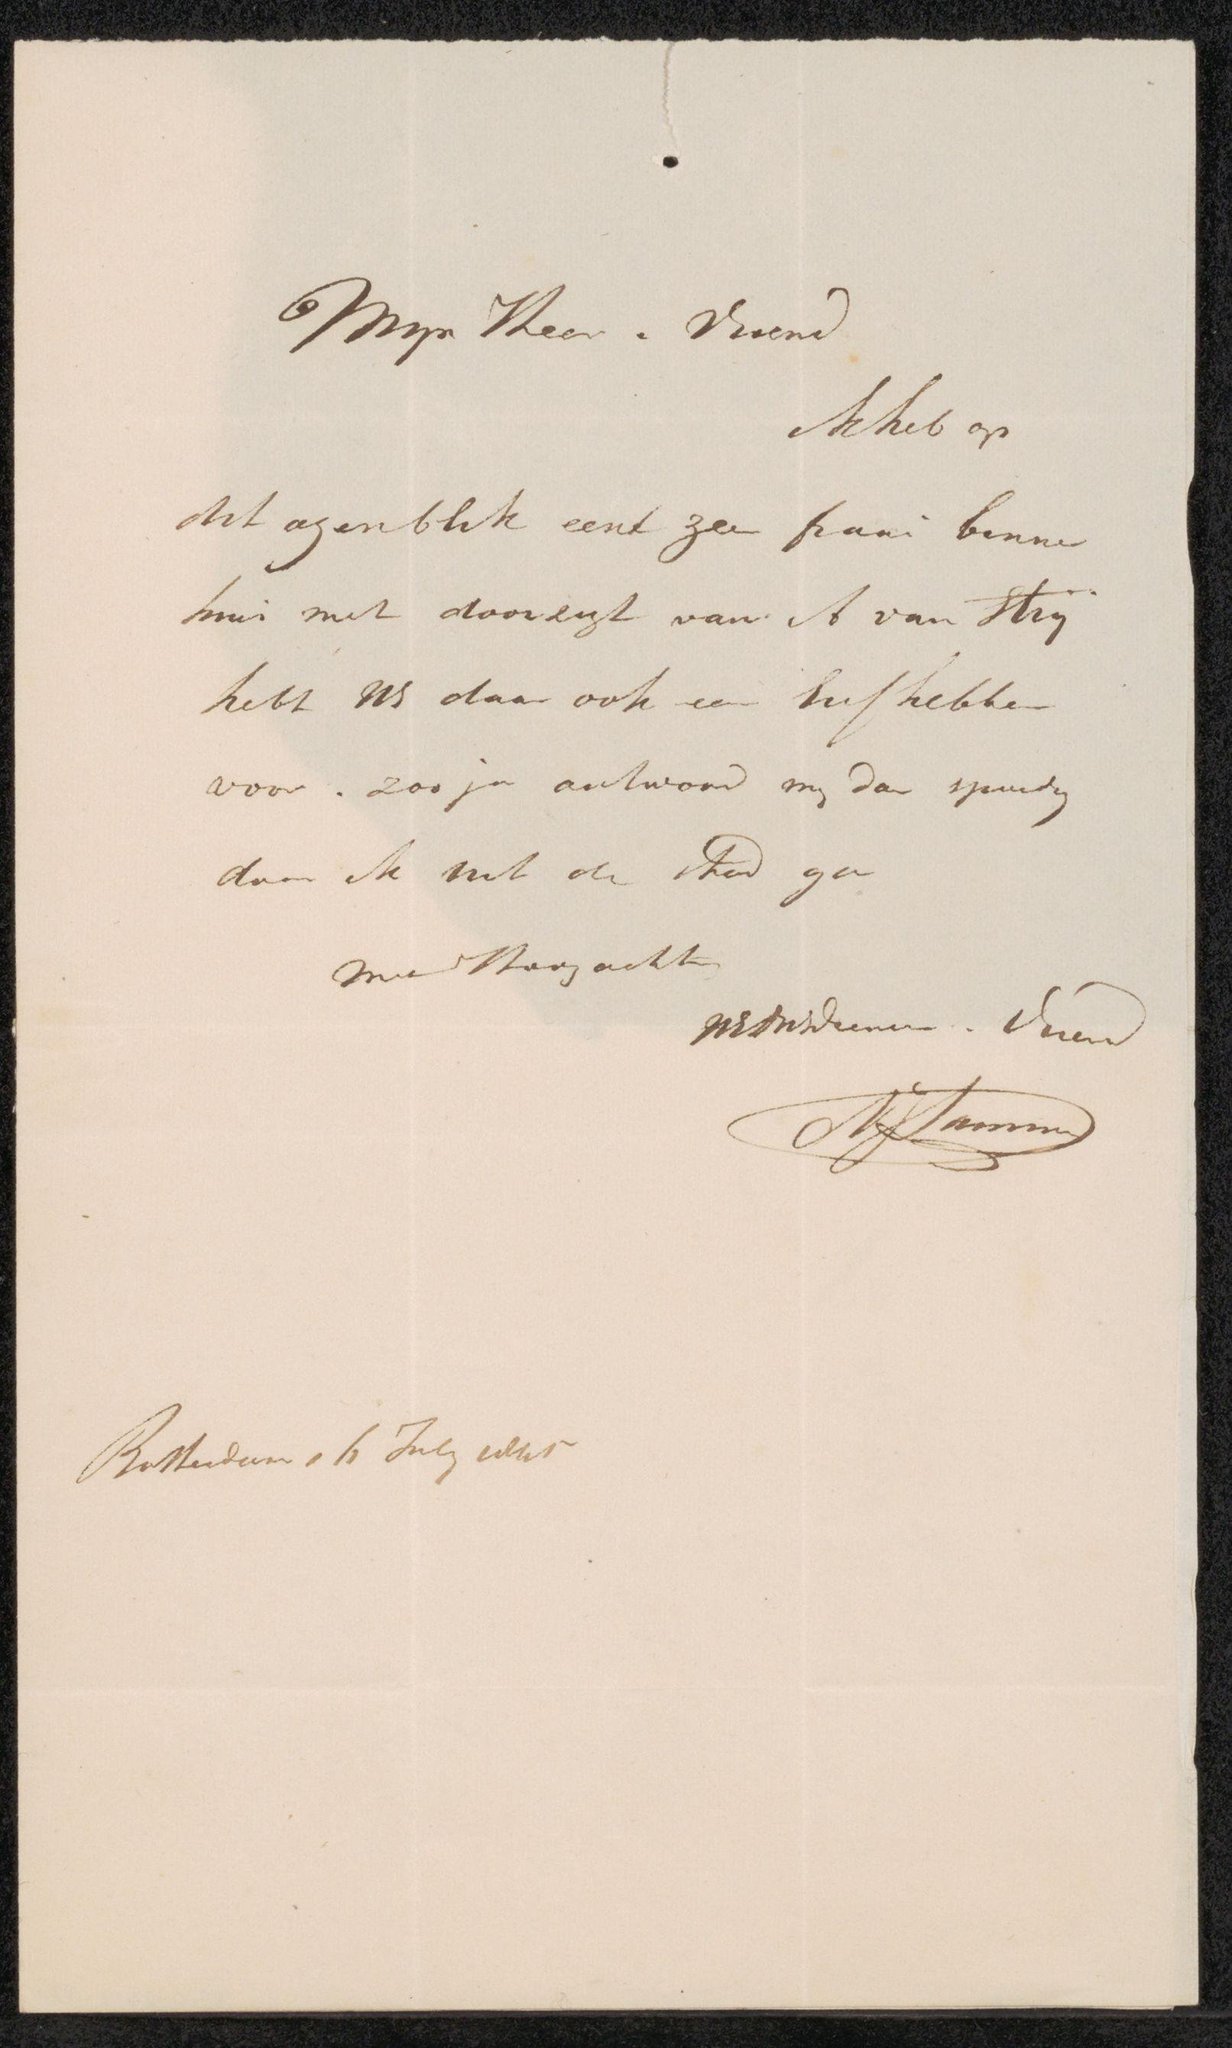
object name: letter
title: Brief aan onbekend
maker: ary johannes lamme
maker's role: draughtsman, print maker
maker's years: 1812-1900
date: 1845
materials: ink, paper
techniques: pen, writing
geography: rotterdam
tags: abraham van strij (i)